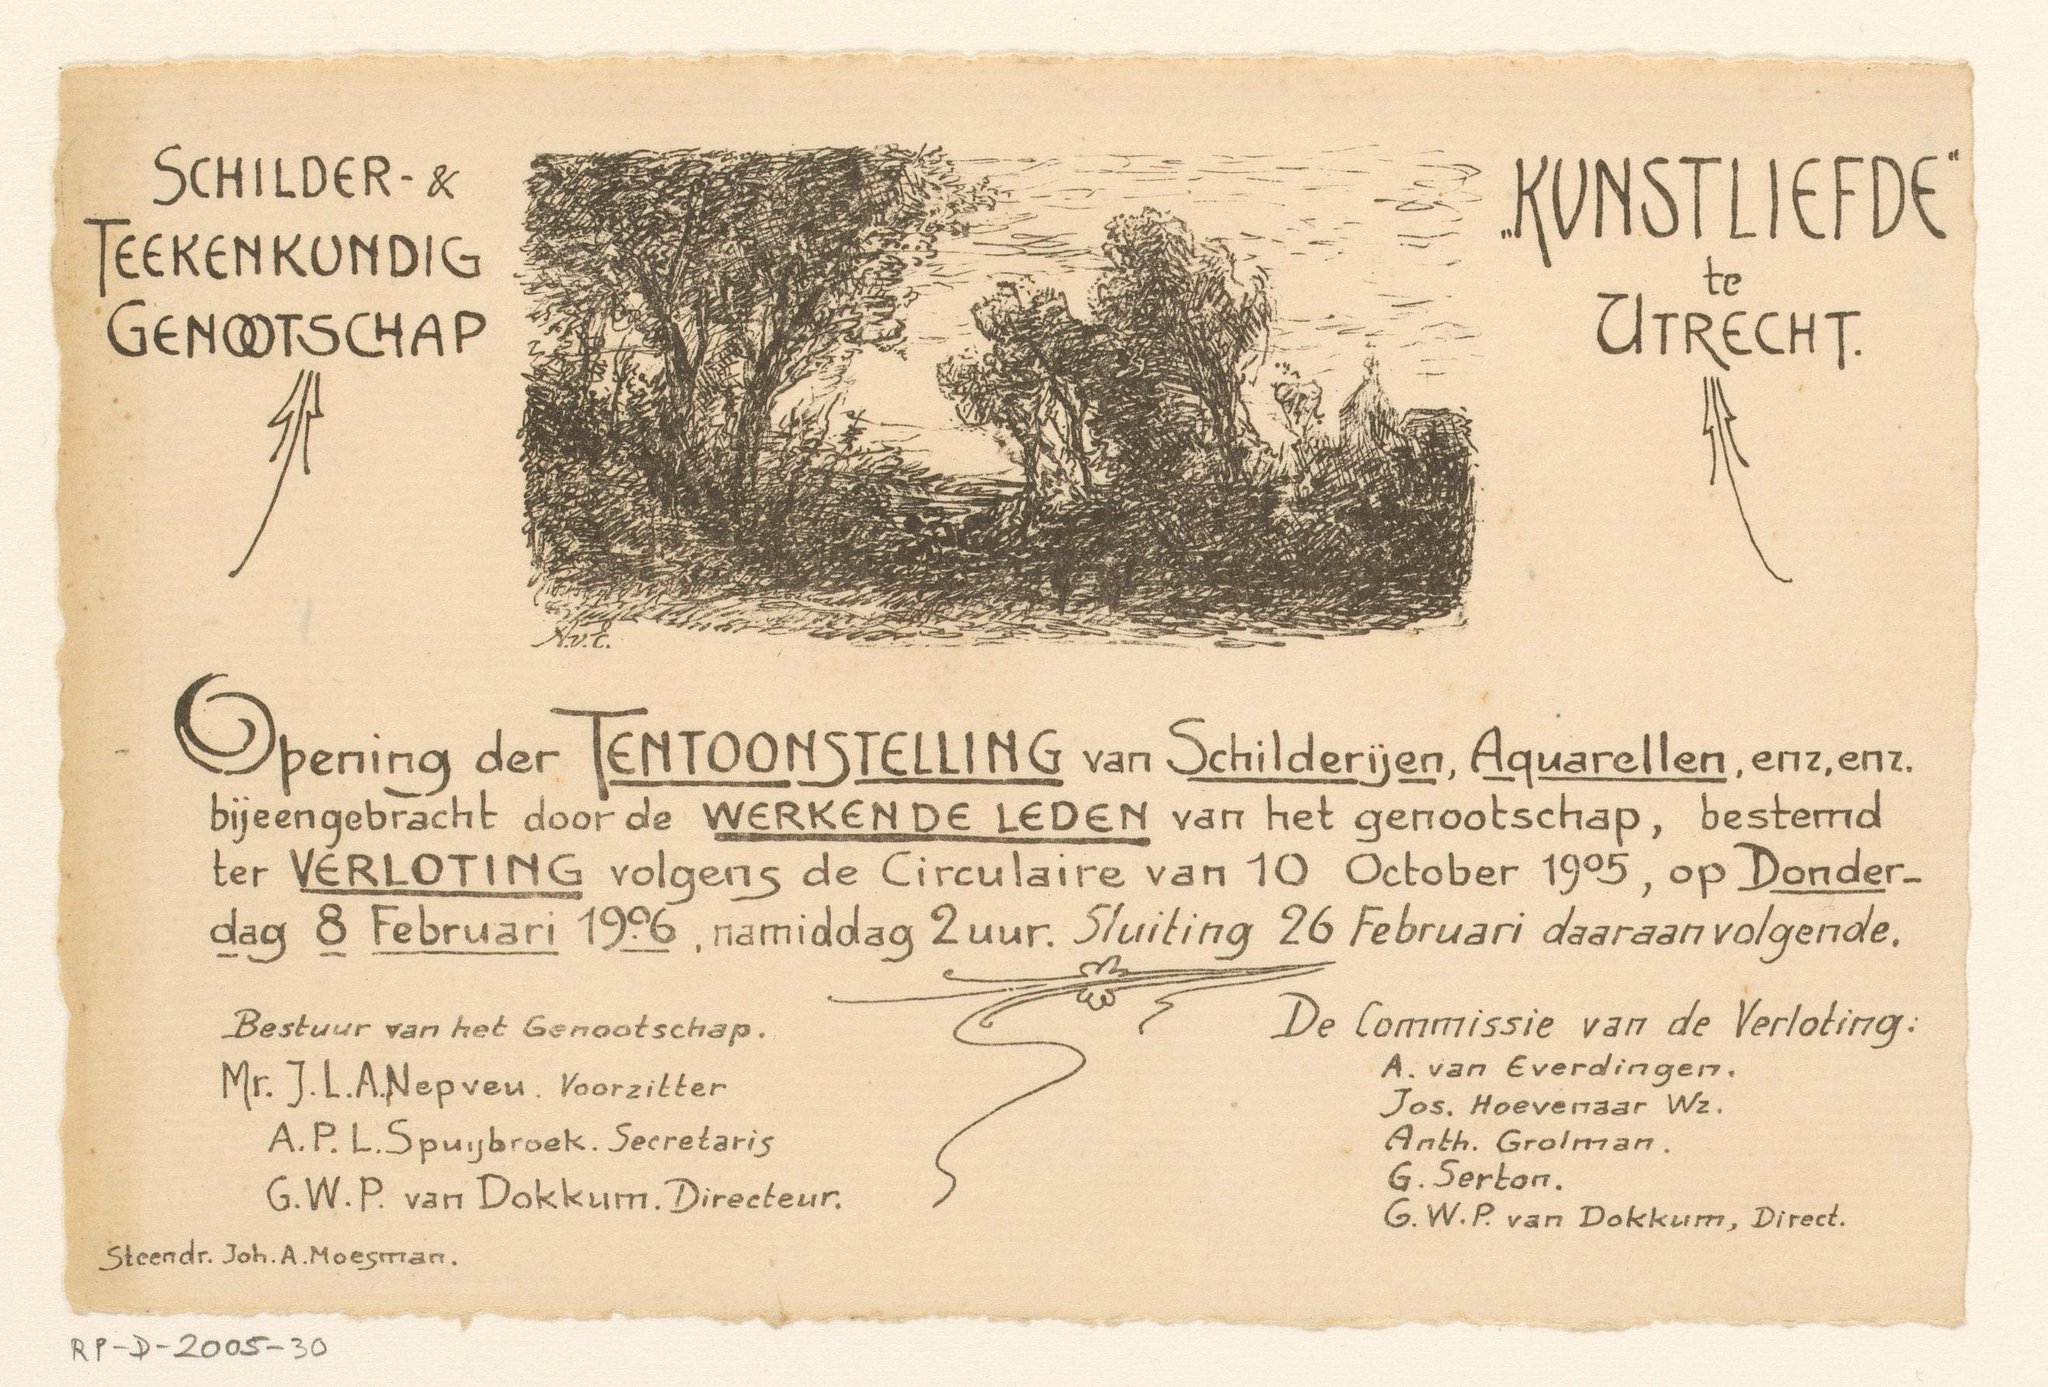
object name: invitation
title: Uitnodiging van Schilder- en Teekenkundig Genootschap "Kunstliefde" voor de opening van de tentoonstelling van werken bijeengebracht door de werkende leden van het genootschap, 8 februari 1906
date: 1902-1906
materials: paper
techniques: lithograph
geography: utrecht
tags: criticizing and discussing art, art criticism, circle, club of artists, collecting and exhibiting products of the fine arts, forest, wood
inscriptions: collector's mark: Lugt 2228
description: Boslandschap. Uitnodiging van Schilder- en Teekenkundig Genootschap "Kunstliefde" voor de opening op 8 februari 1906 van de tentoonstelling van werken bijeengebracht door de werkende leden van het genootschap, bestemd voor verloting.